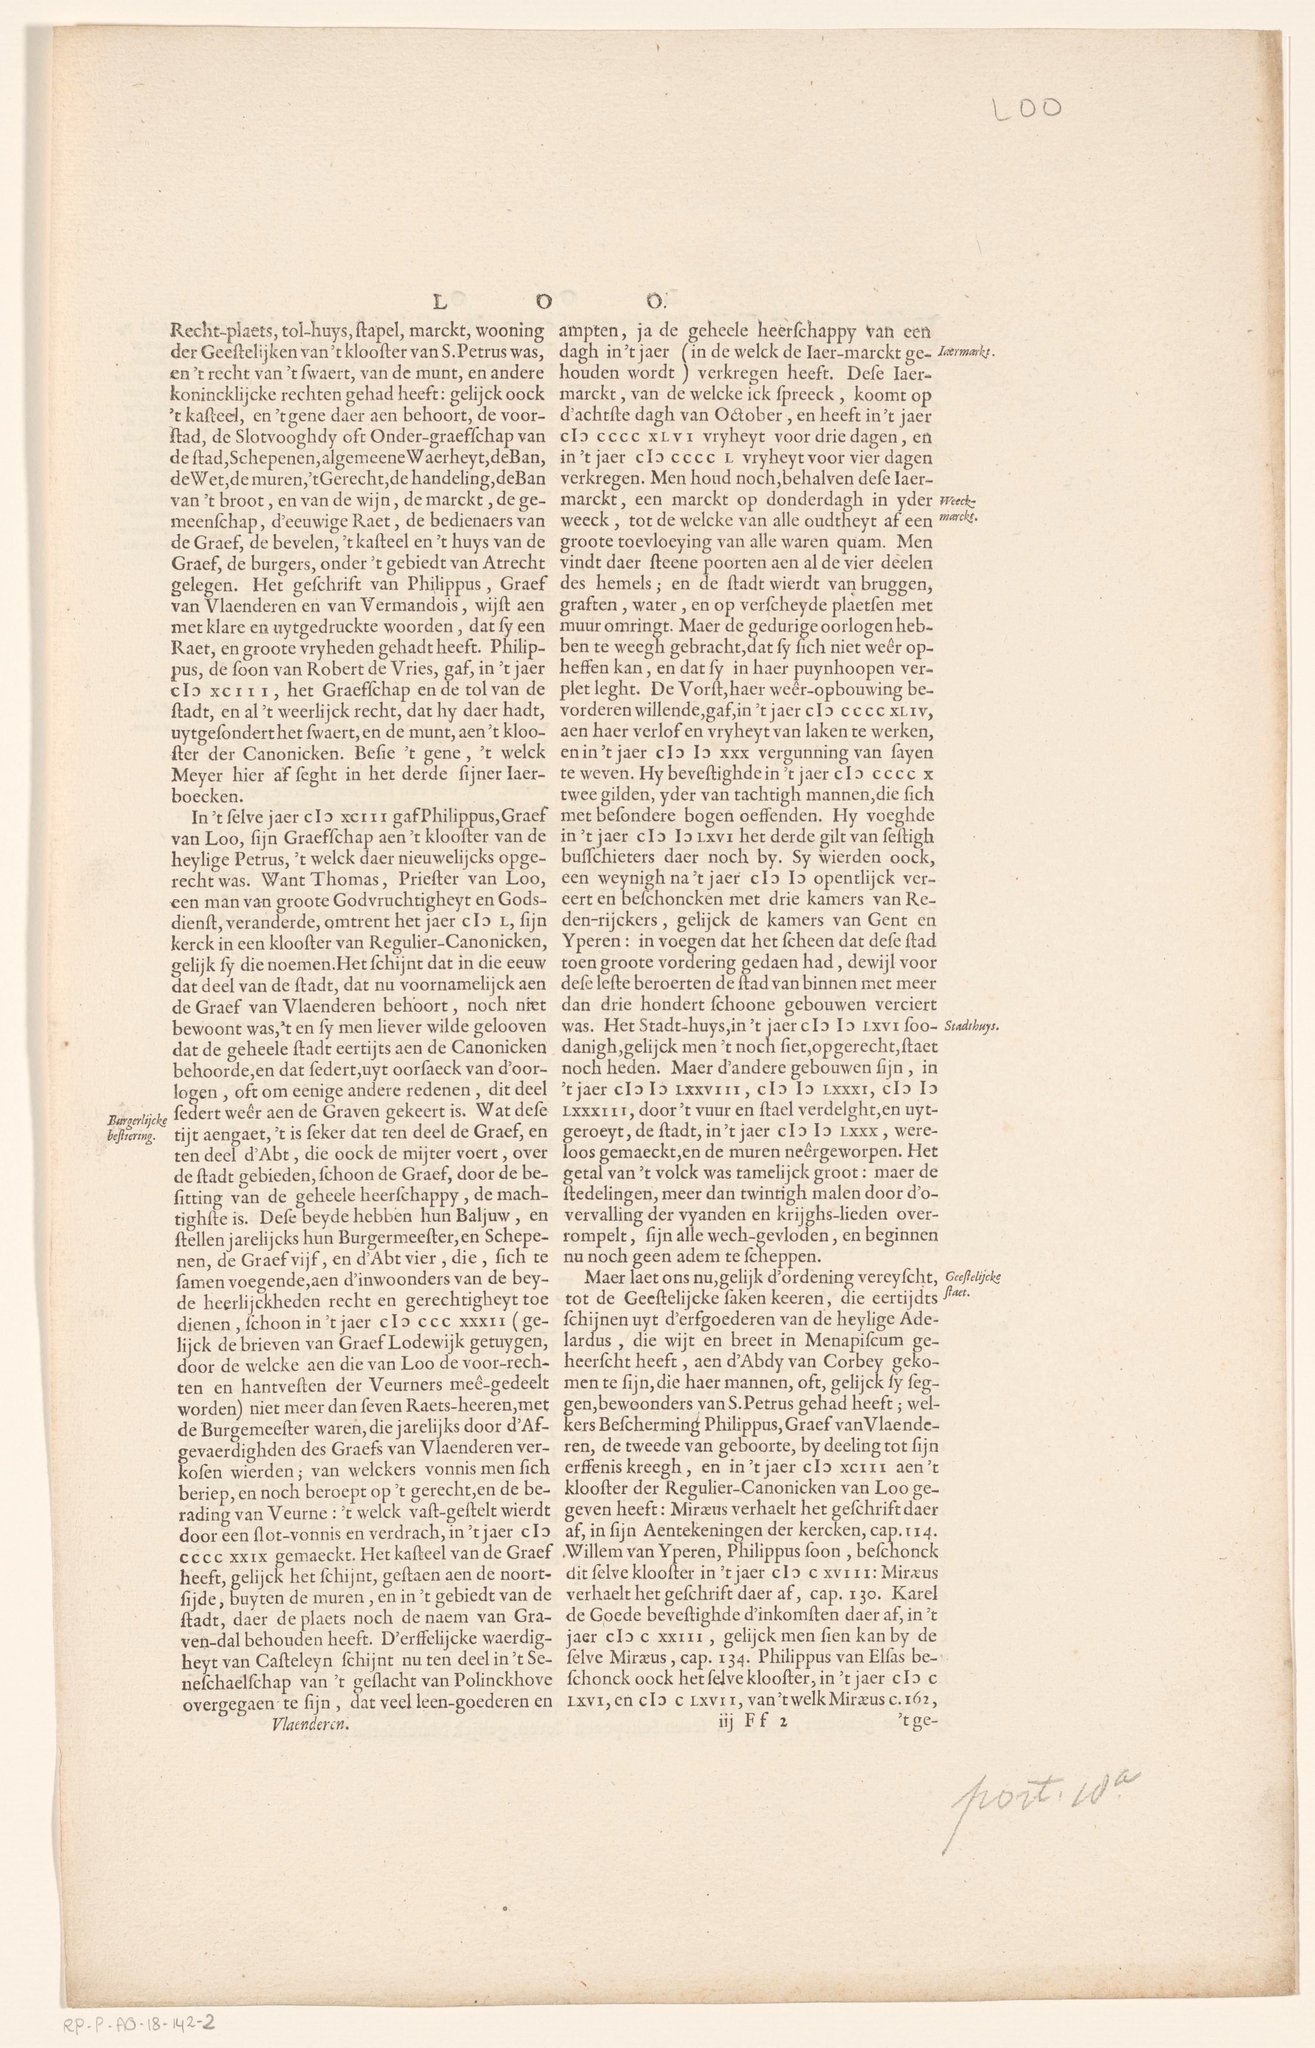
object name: text sheet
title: Deel van de beschrijving van Lo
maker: johannes willemszoon blaeu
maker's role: printer, publisher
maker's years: 1596-1673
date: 1652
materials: paper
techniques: letterpress printing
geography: amsterdam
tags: lo (lo-reninge)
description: Tekst gebruikt in: Blaeu, Johannes Willemszoon. Toonneel der steden van de Vereenighde Nederlanden. 2 delen. Amsterdam: Johannes Willemszoon Blaeu, 1652, dl. 2. Zie ook: RP-P-AO-18-142-1.